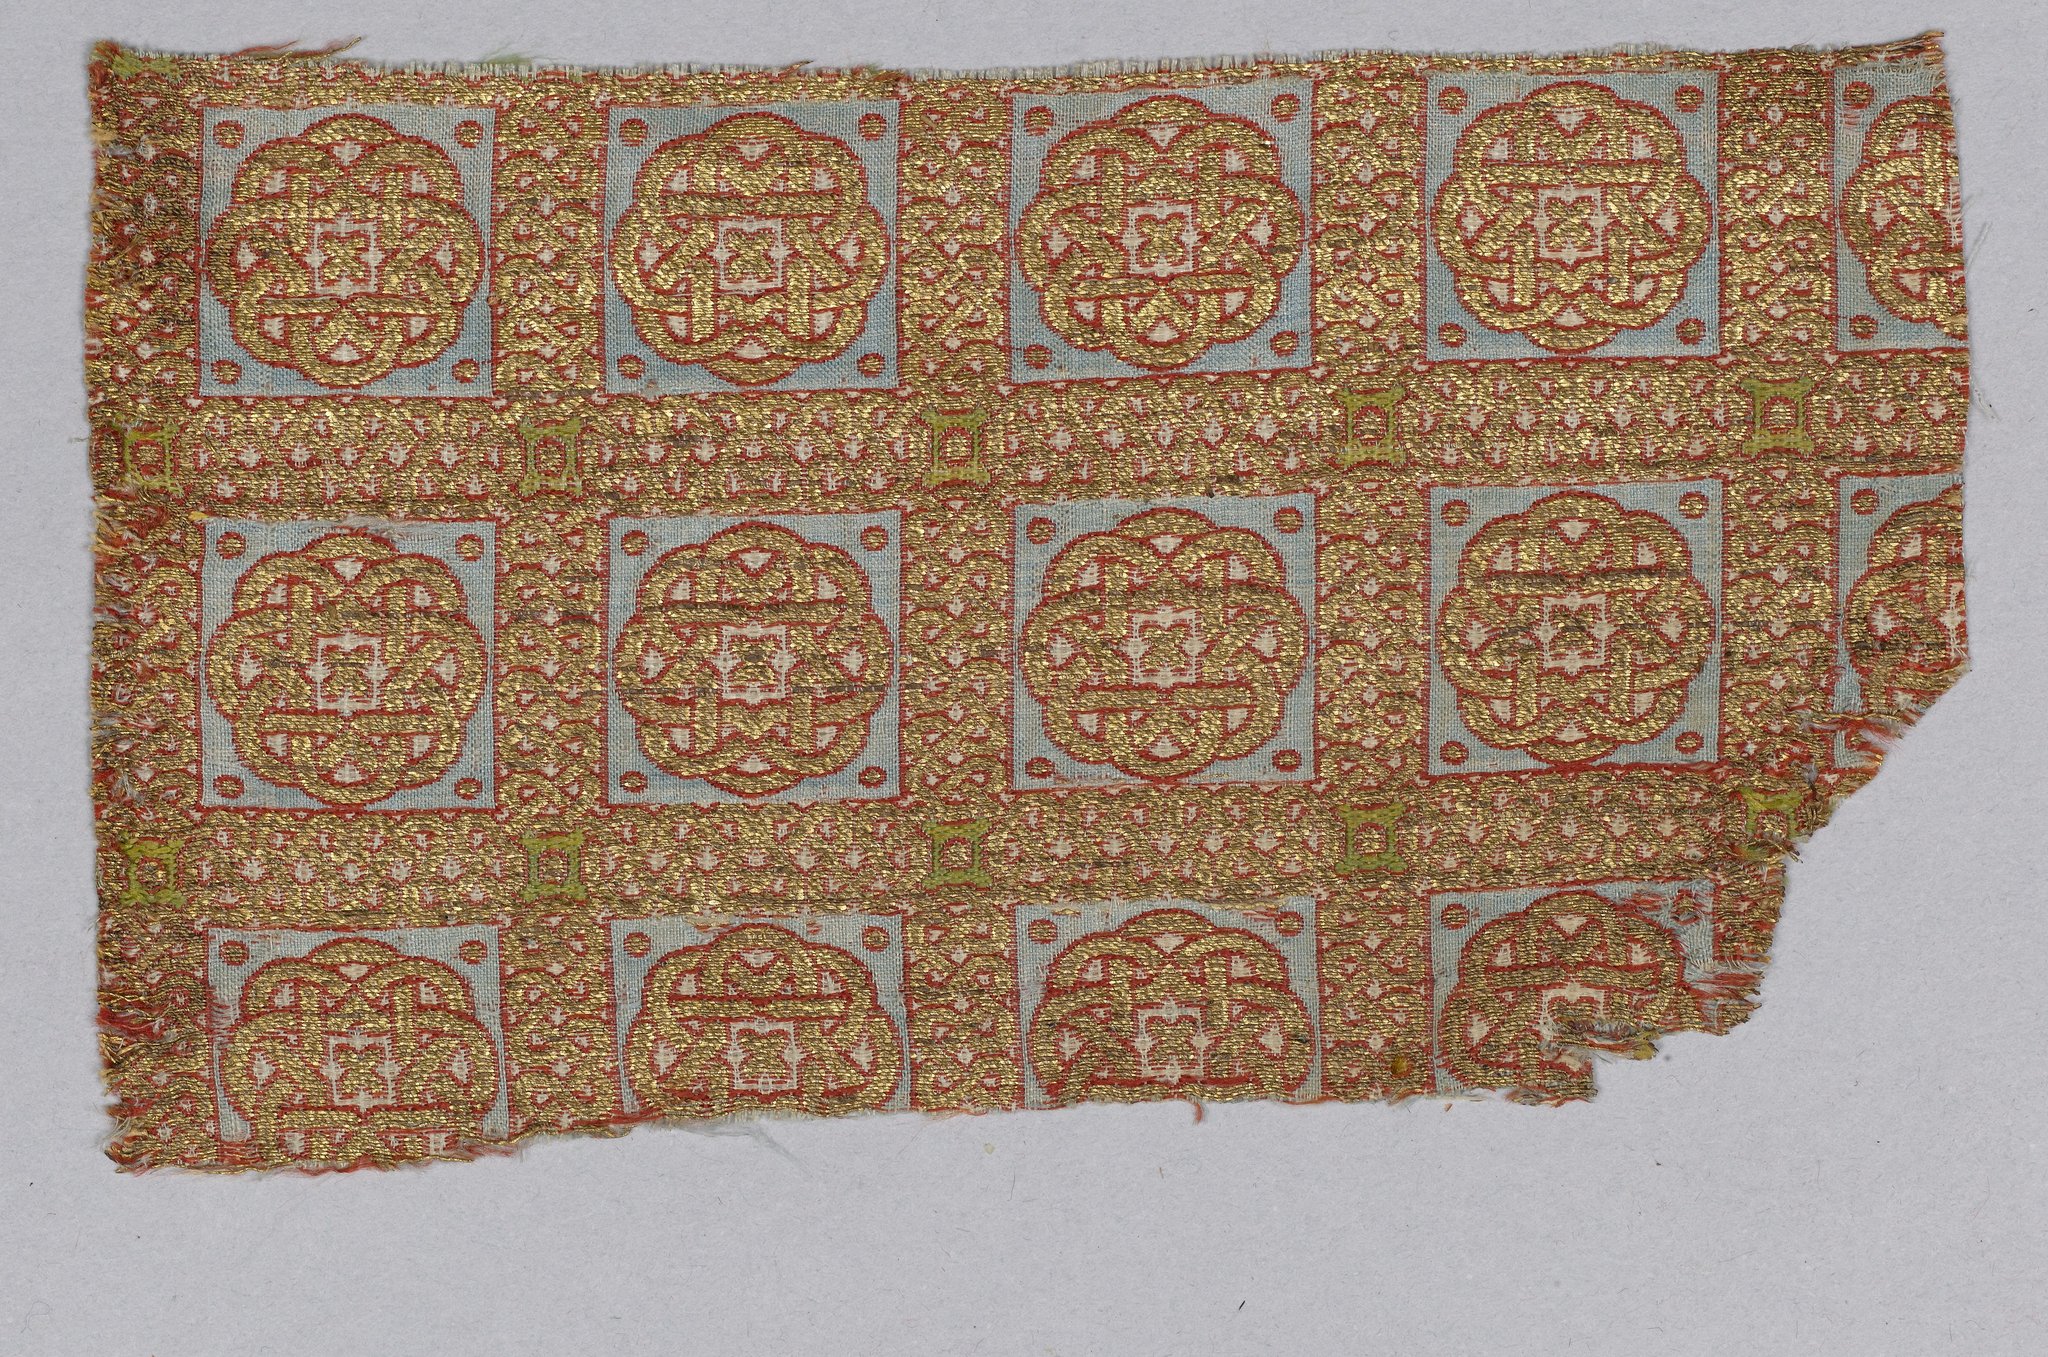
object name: fragment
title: Textile Fragment from the Dalmatic of San Valerius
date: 1201-1300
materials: animal substrate, gilt, silk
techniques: lampas, weave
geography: spain